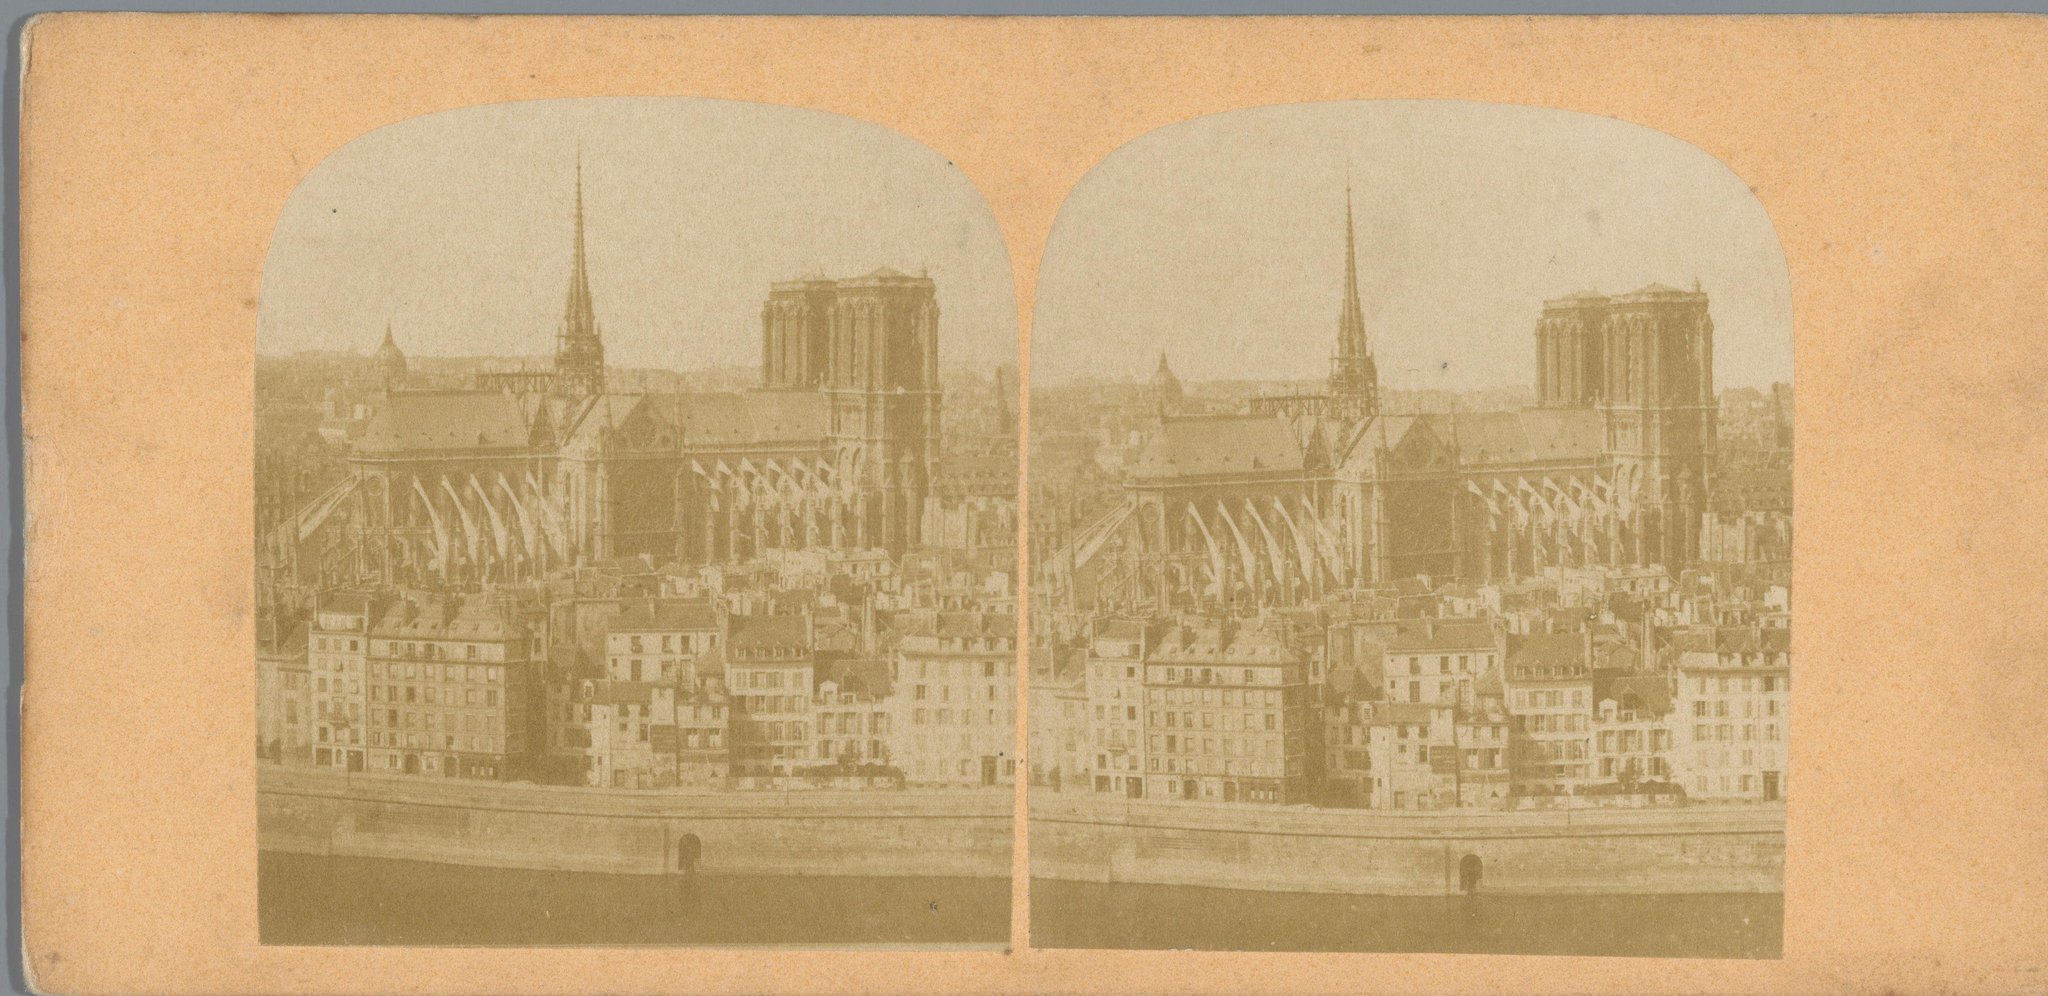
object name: stereograph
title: Gezicht op de Notre-Dame in Parijs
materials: cardboard, photographic support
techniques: albumen print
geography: paris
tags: church (exterior)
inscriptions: name: ‘LeCocq-Frene Estampes Photographies Plans et Guides pour Voyageurs Vues pr. Stereoscope’, annotation: ‘zelf gekocht in Parijs 27 Augustus 1860’, inscription: ‘(Cote de) Notre Dame’